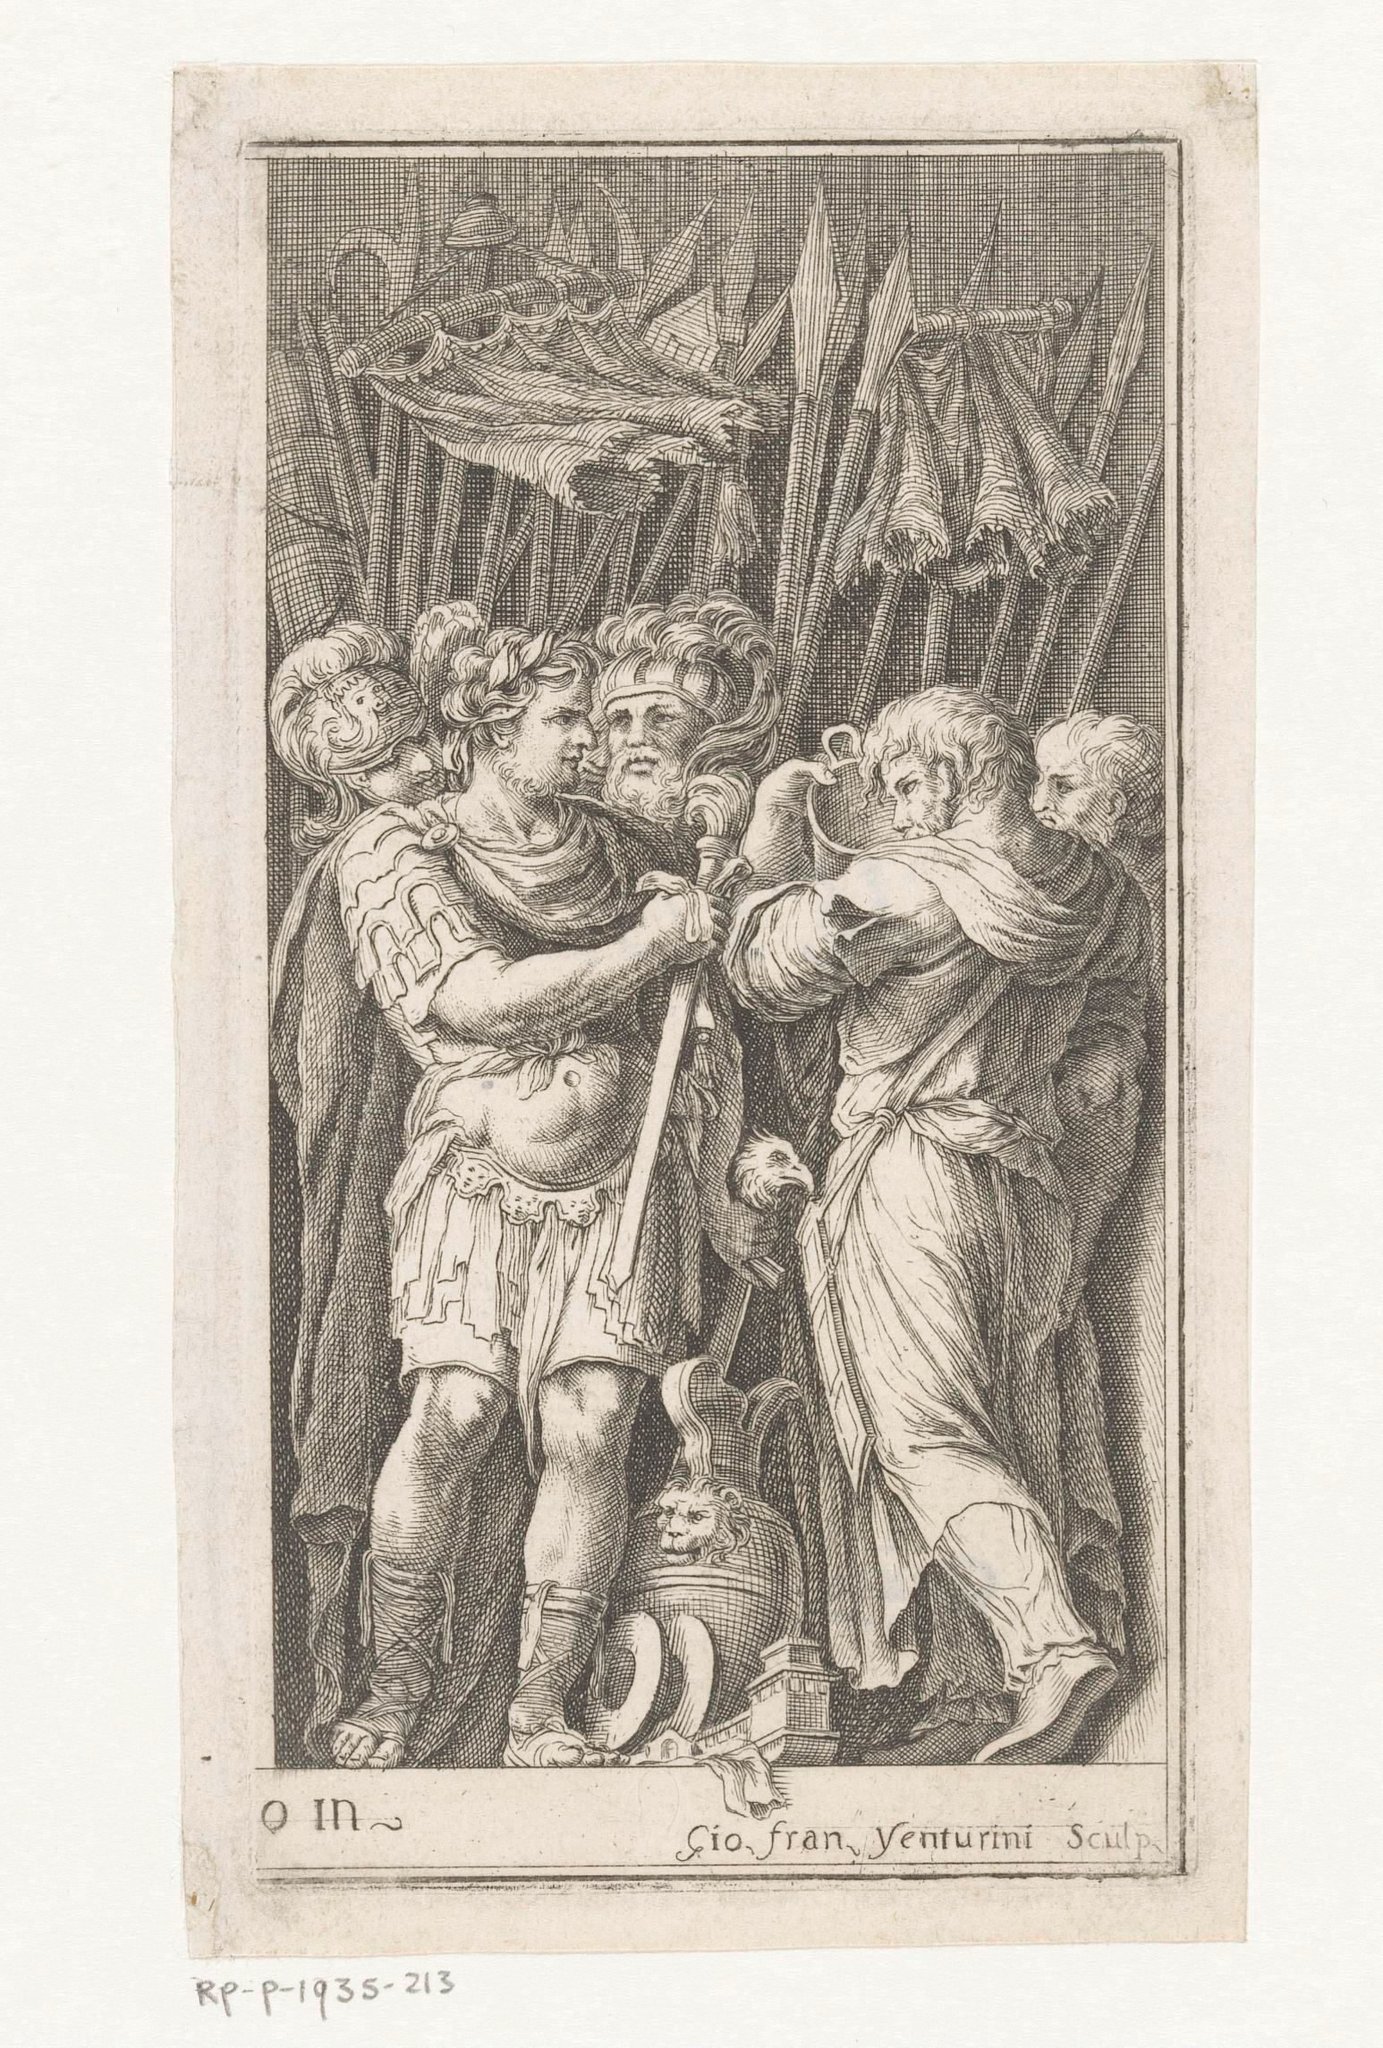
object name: print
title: Soldaten met wapens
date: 1660-1710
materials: paper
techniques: engraving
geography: italy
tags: casting weapons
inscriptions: collector's mark: Lugt 2228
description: Verscheidene soldaten met op de achtergrond lansen en andere wapens.